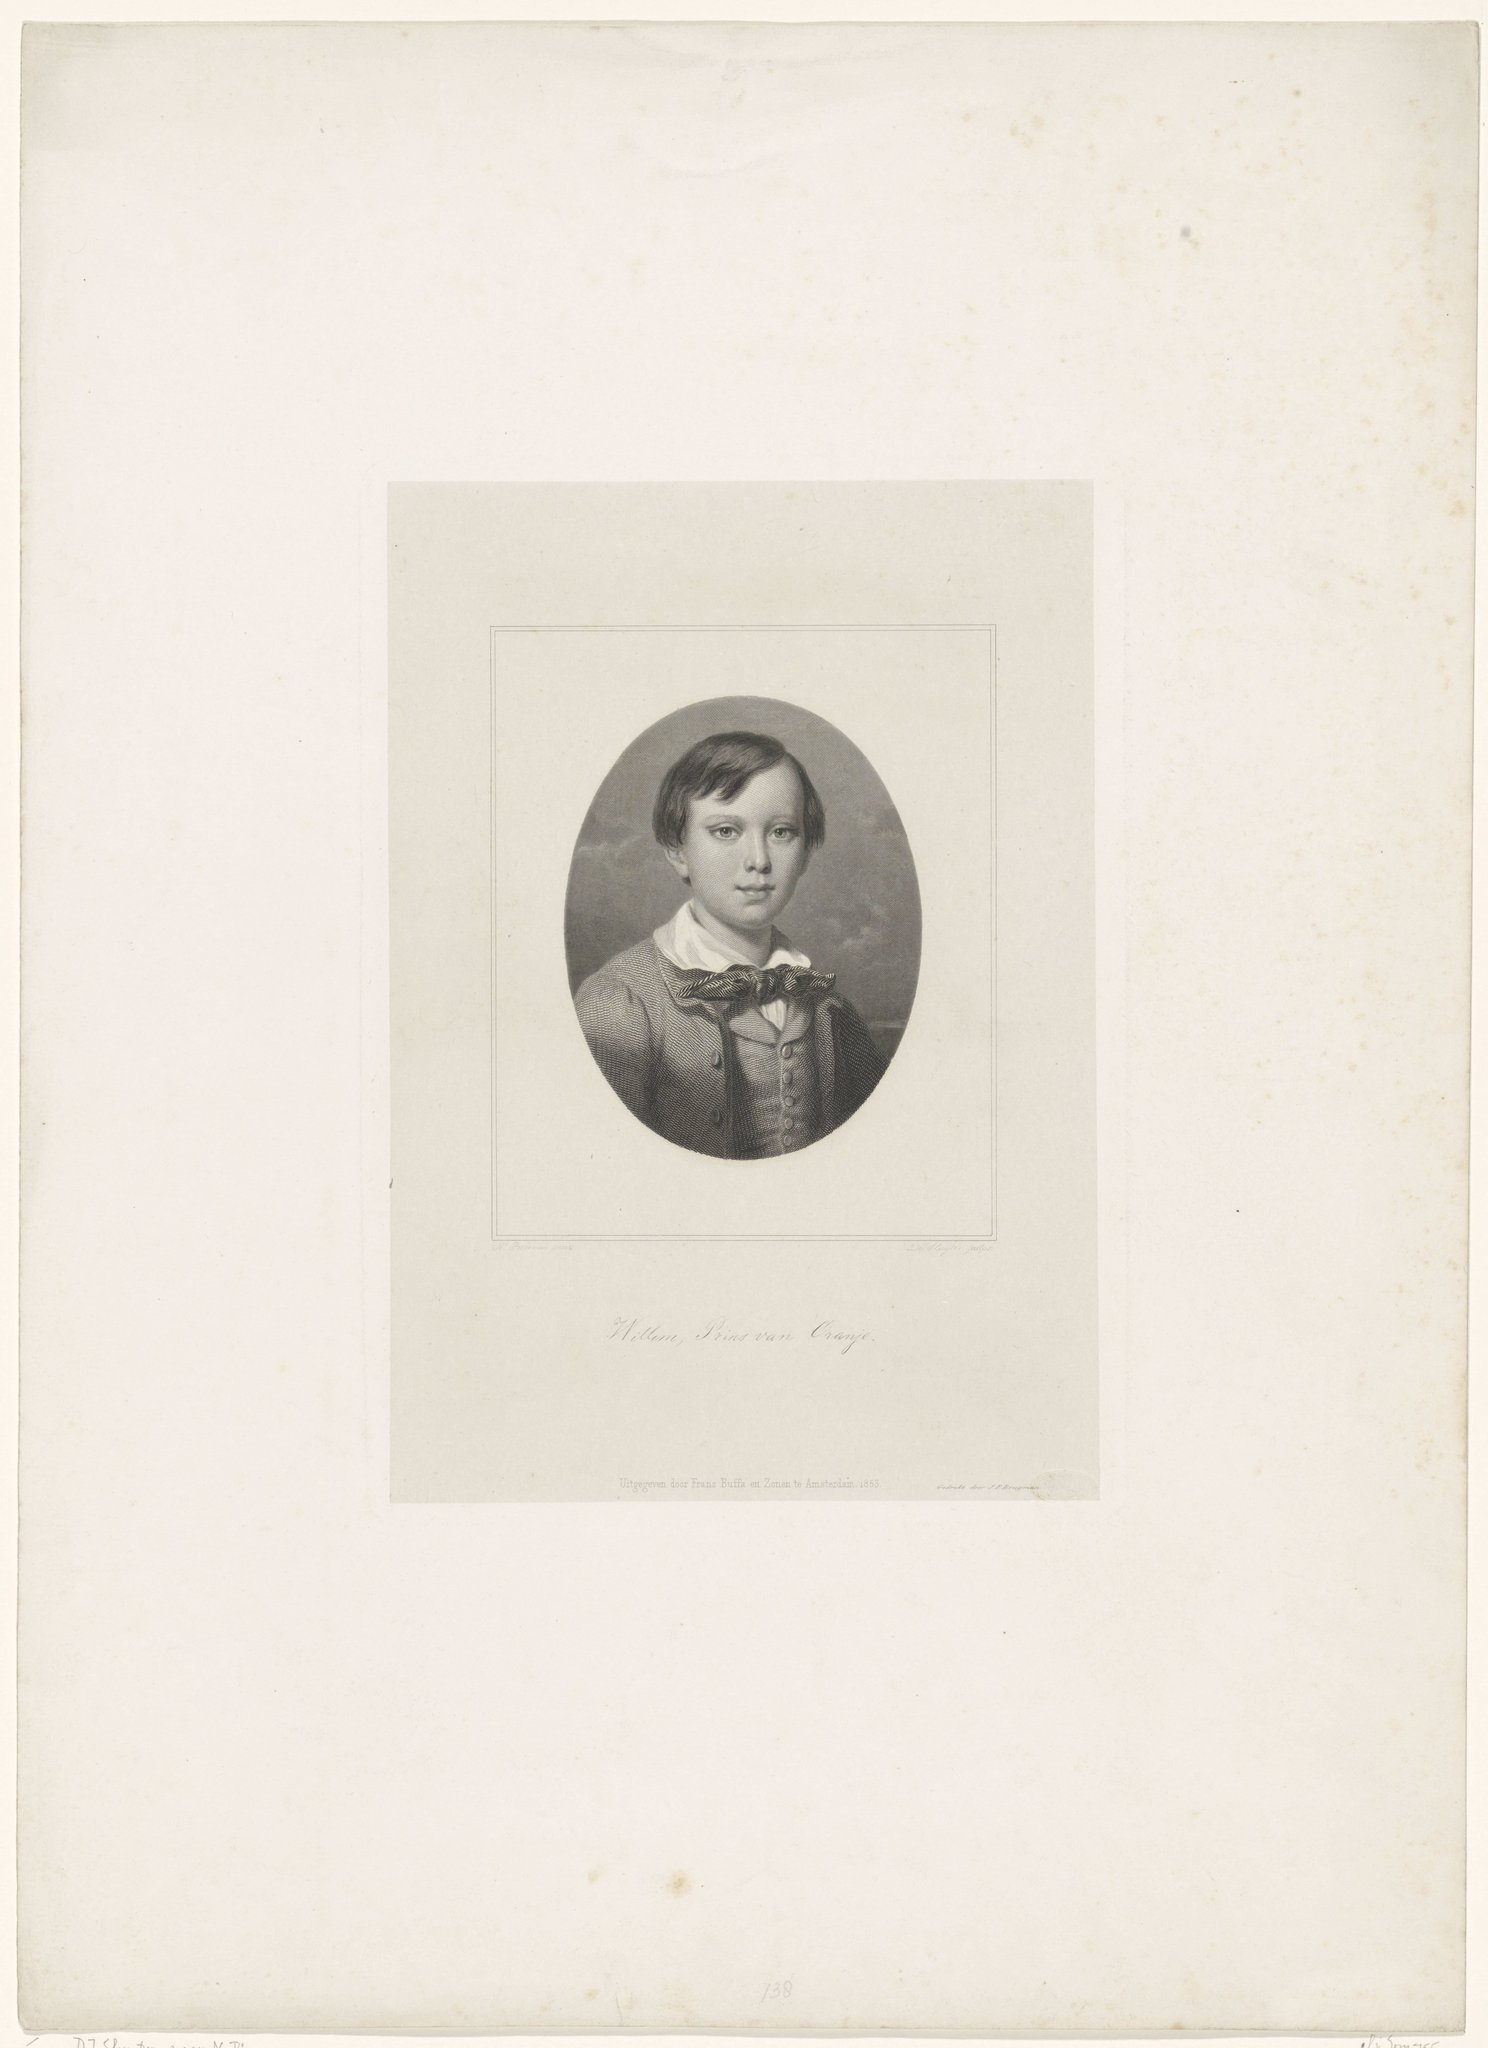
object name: print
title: Portret van Willem, prins der Nederlanden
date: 1853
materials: paper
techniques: engraving, etching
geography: amsterdam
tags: the hague, willem (prins der nederlanden)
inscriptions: check stamp: ‘Frans Buffa & Zonen’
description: De hier vermelde titel verwijst naar de hoogst verkregen titel van de geportretteerde, niet per se naar de titel die de geportretteerde op deze voorstelling draagt.